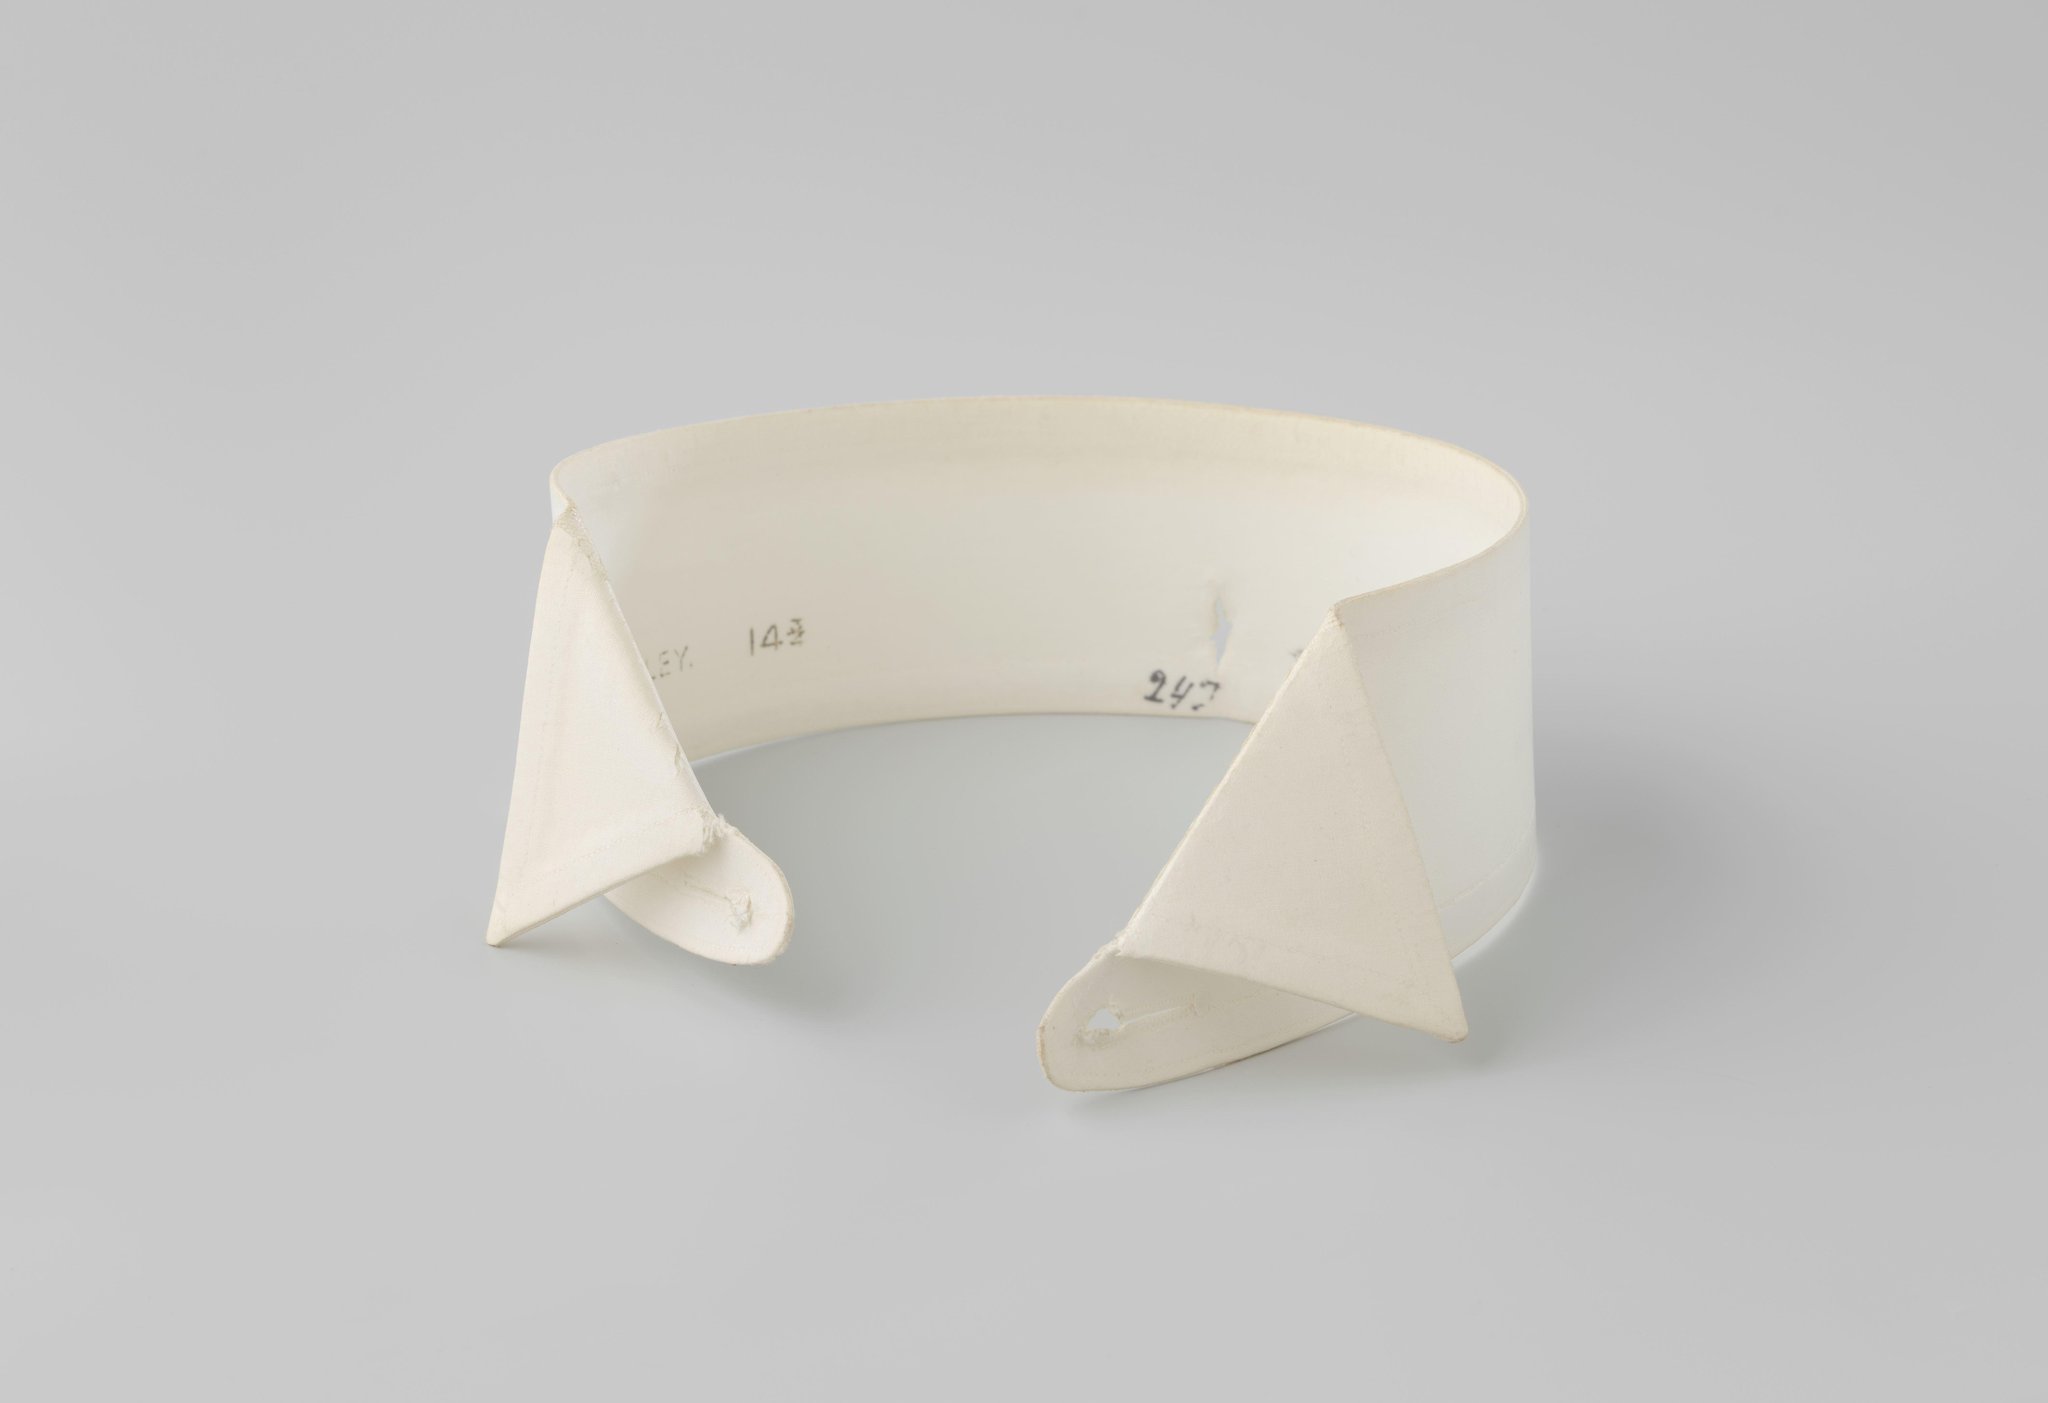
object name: collar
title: Vadermoordenaar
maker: Anonymous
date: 1850-1920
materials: textile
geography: netherlands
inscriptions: inscription: ‘247 D.G '526)’, name: ‘GEVERS’, size: ‘14¾’, inscription: ‘MADE IN ENGLAND FOR / DE PINNA / NEW YORK’, mark: ‘PURLEY’